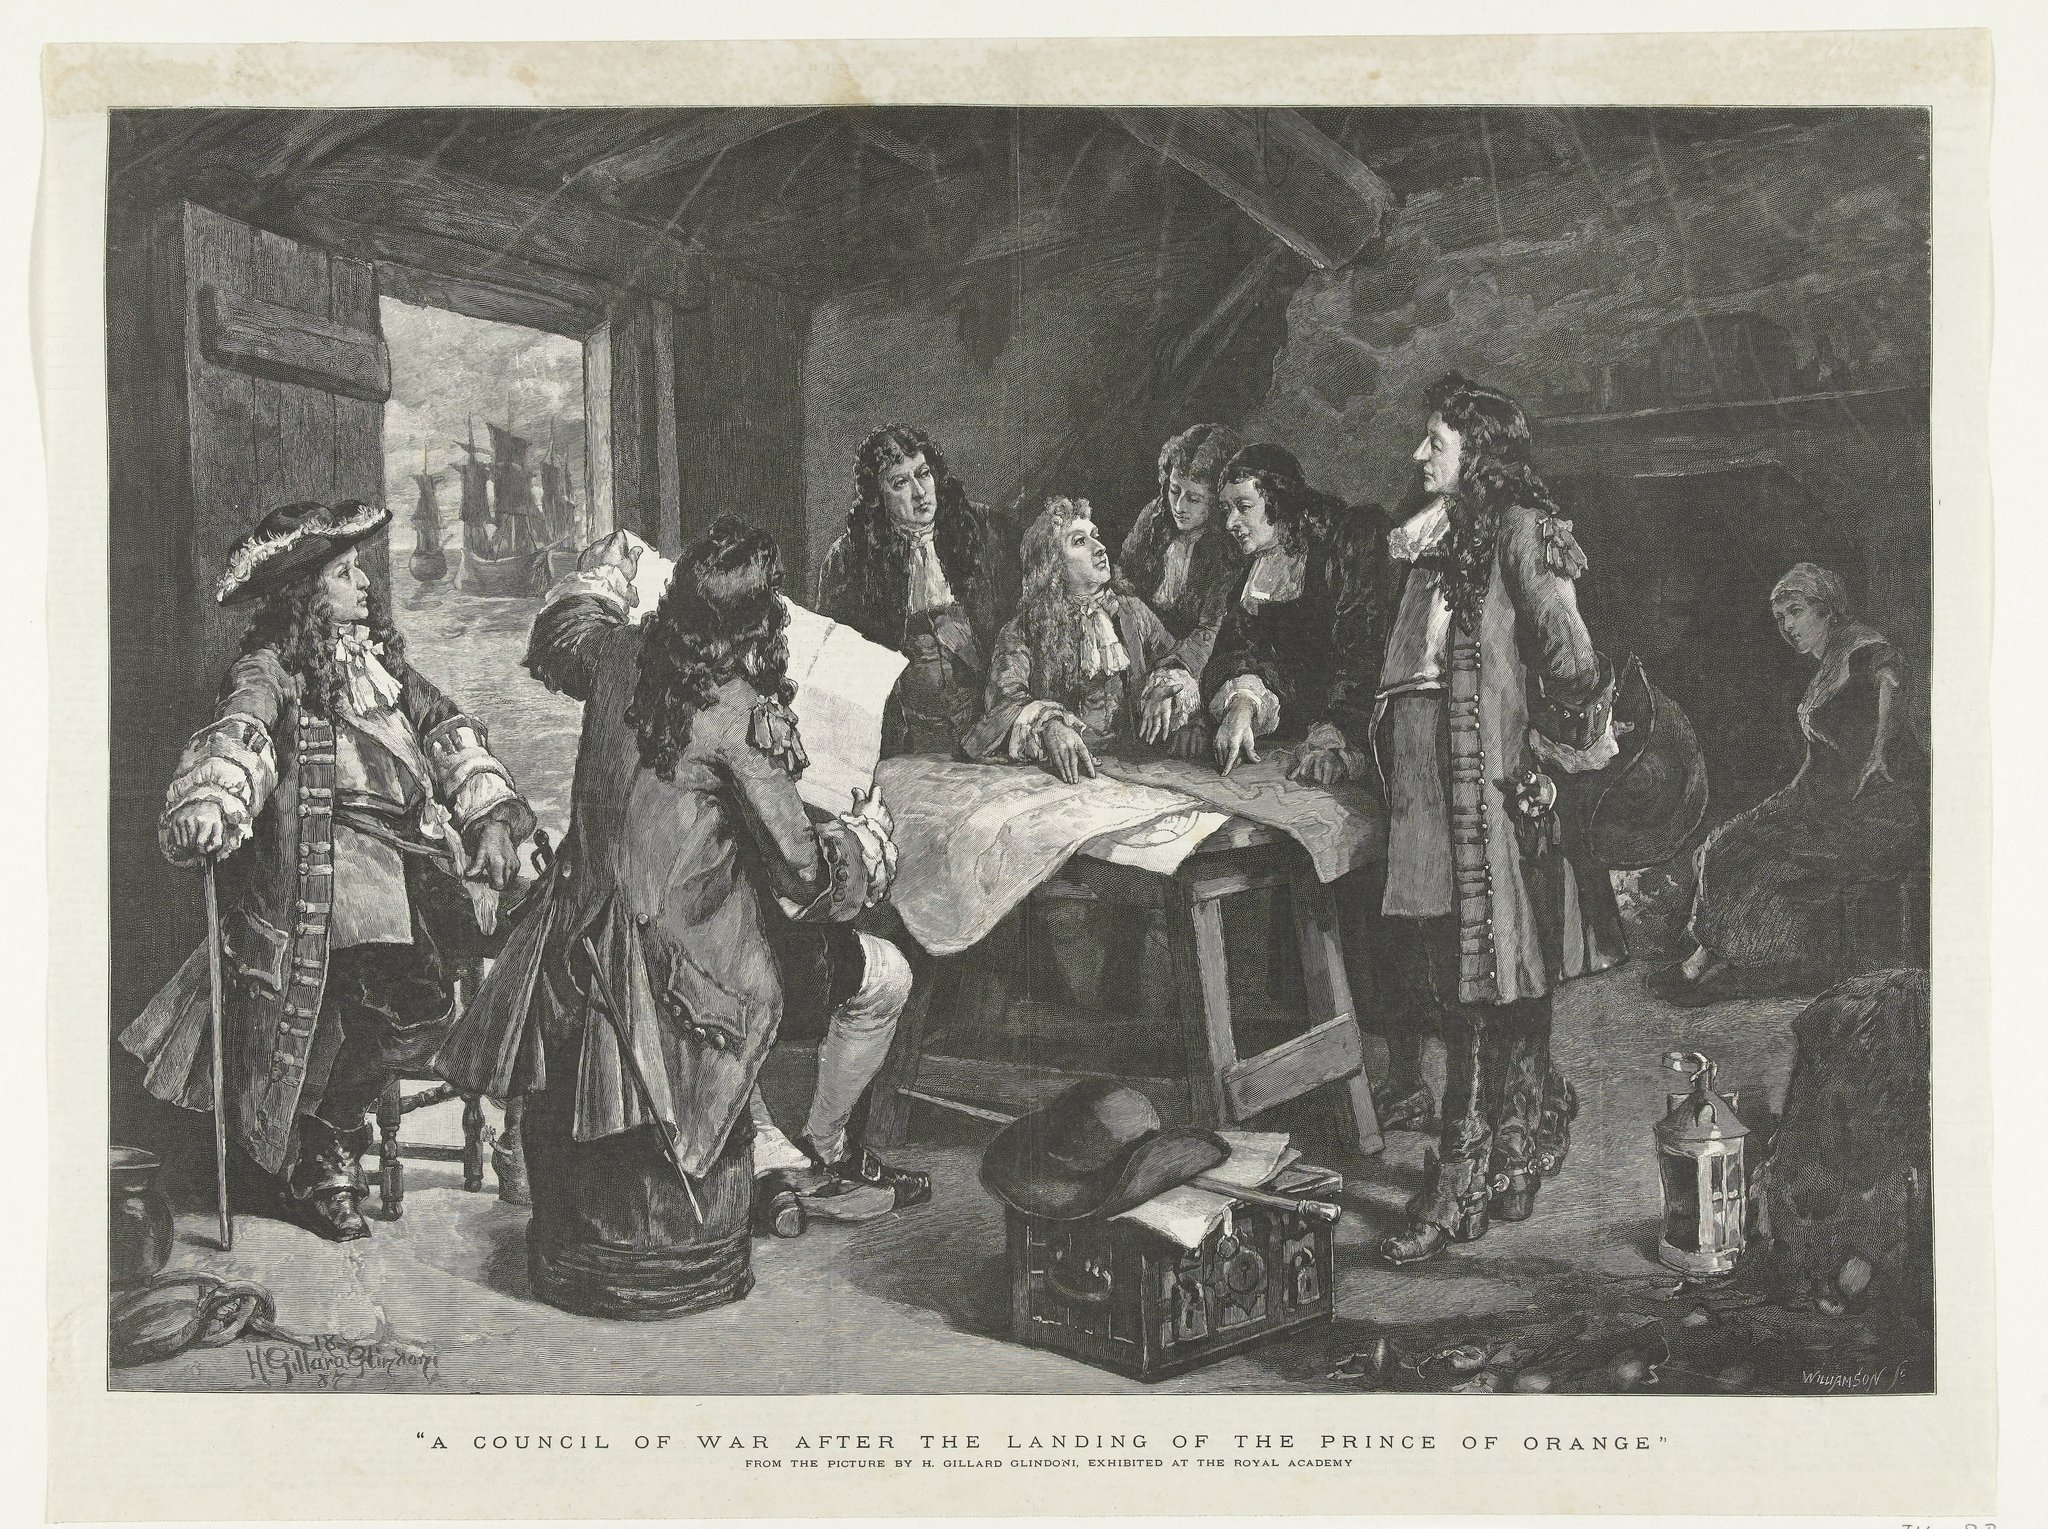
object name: print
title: "A council of war after the landing of the Prince of Orange"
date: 1888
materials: paper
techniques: letterpress printing, engraving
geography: england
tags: william iii (prince of orange and king of england, scotland, and ireland), council of war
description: Prins Willem III houdt krijgsberaad met de leden van zijn staf in een eenvoudige vissershut, na zijn landing op 15 november 1688. Bedrukt op achterzijde met tekst in het Engels.